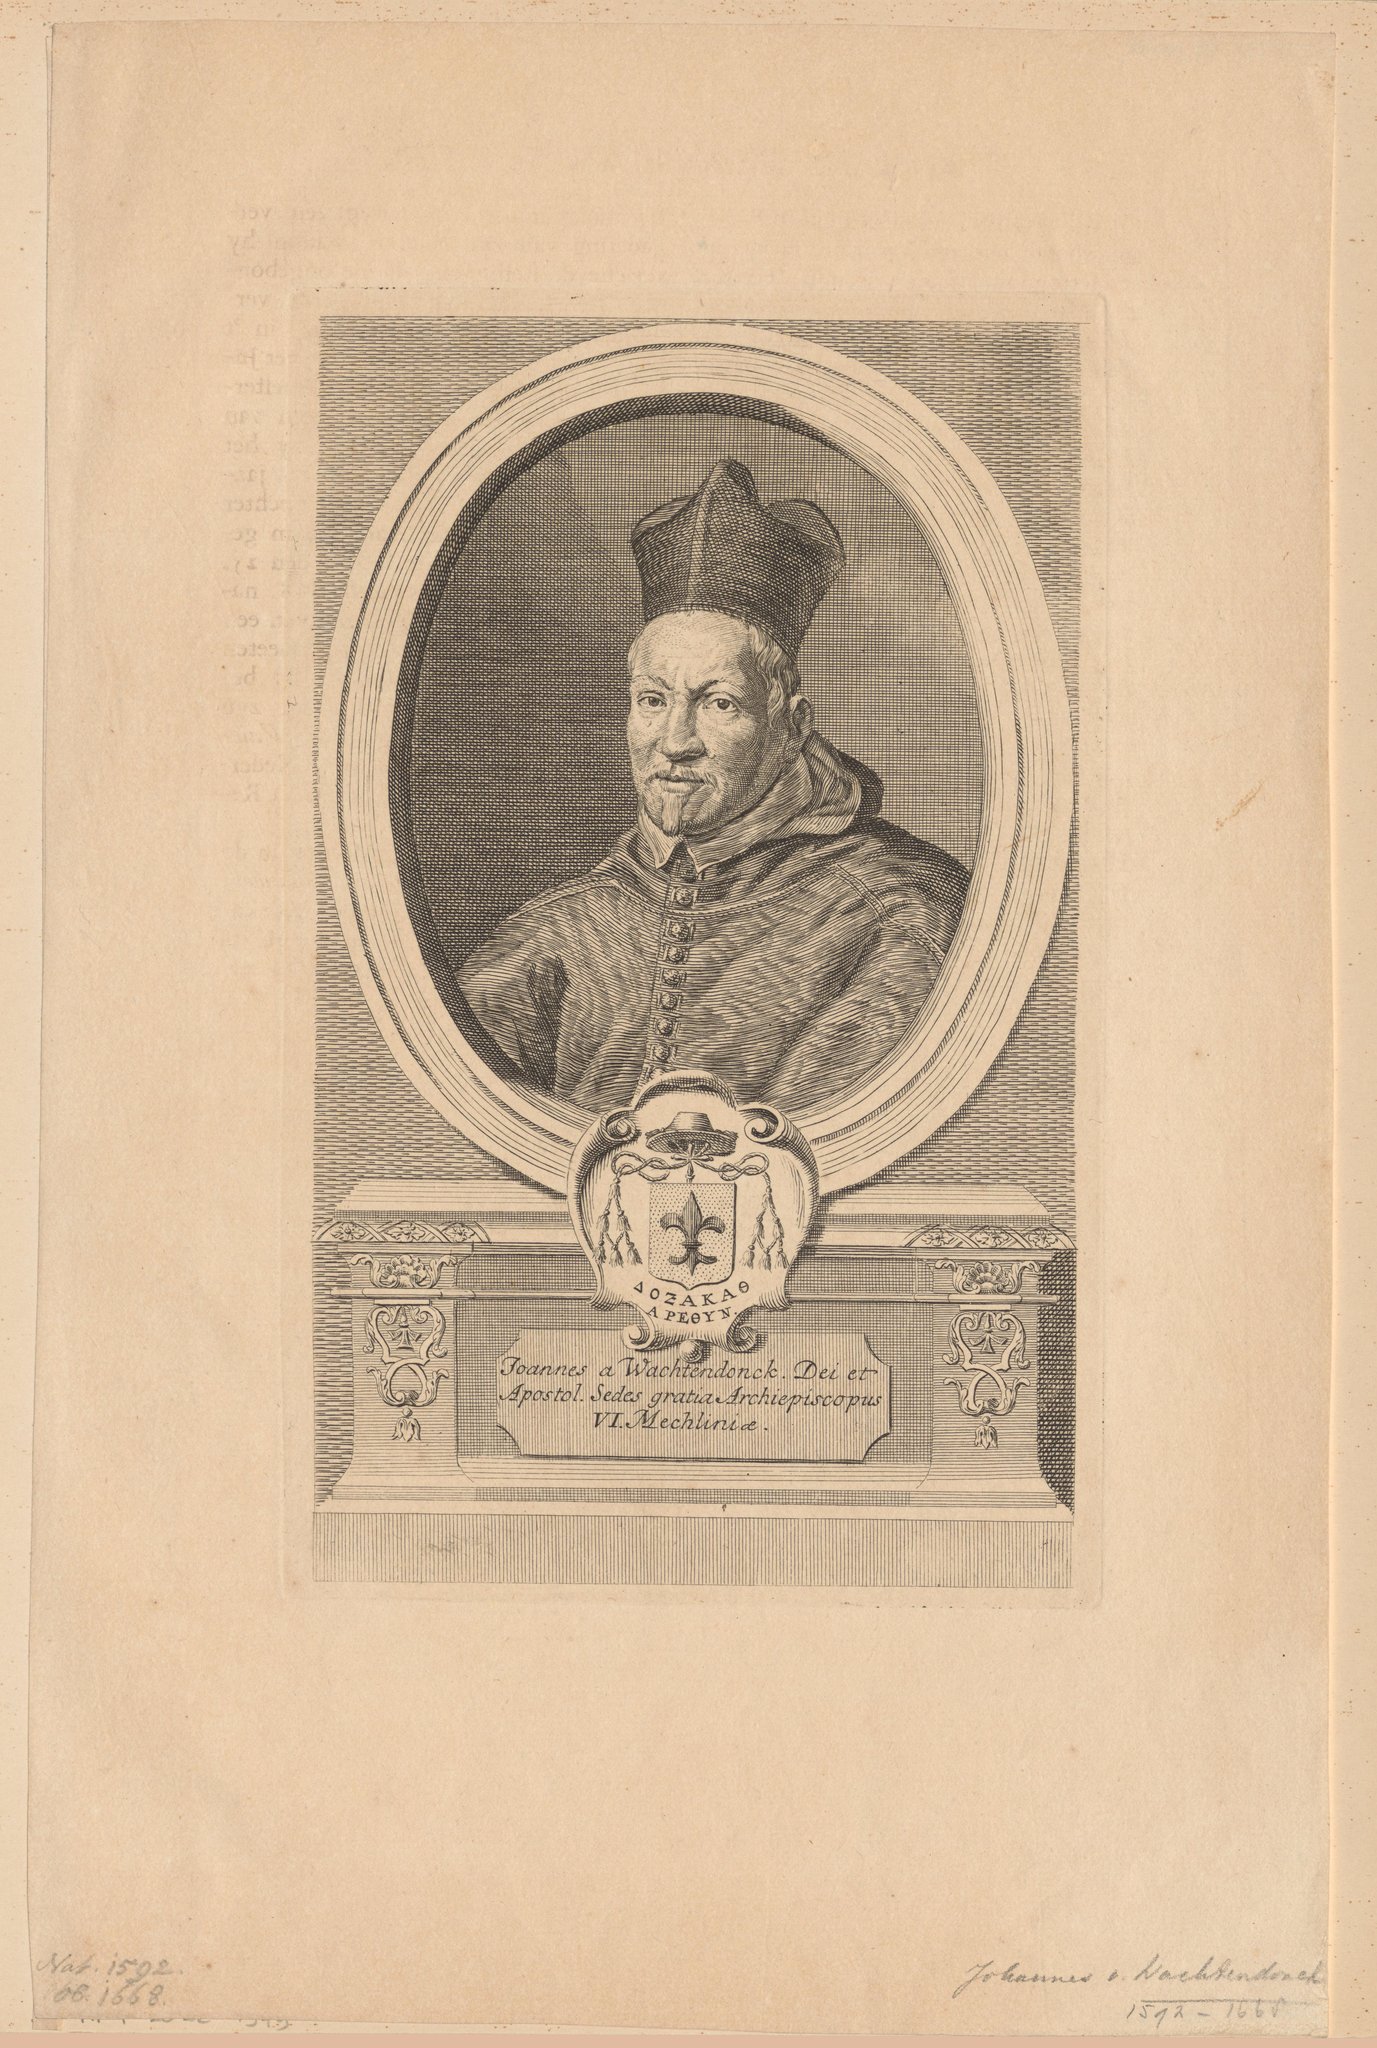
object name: print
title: Portret van Johannes Wachtendonck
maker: Anonymous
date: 1725-1727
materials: paper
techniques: engraving, etching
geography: southern netherlands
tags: mechelen, brussels, johannes wachtendonck, archbishop, bishop, etc. (roman catholic), historical persons, armorial bearing, heraldry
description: Prent waarschijnlijk uit: Gestel, Cornelis van. Historia sacra et profana Archiepiscopatus Mechliniensis (...). Den Haag: Christiaan van Lom, 1725. Of uit: Sanderus, Antonius. Groot kerkelyk toneel des hertogdoms van Brabant (...). Den Haag: Christiaan van Lom, 1727.